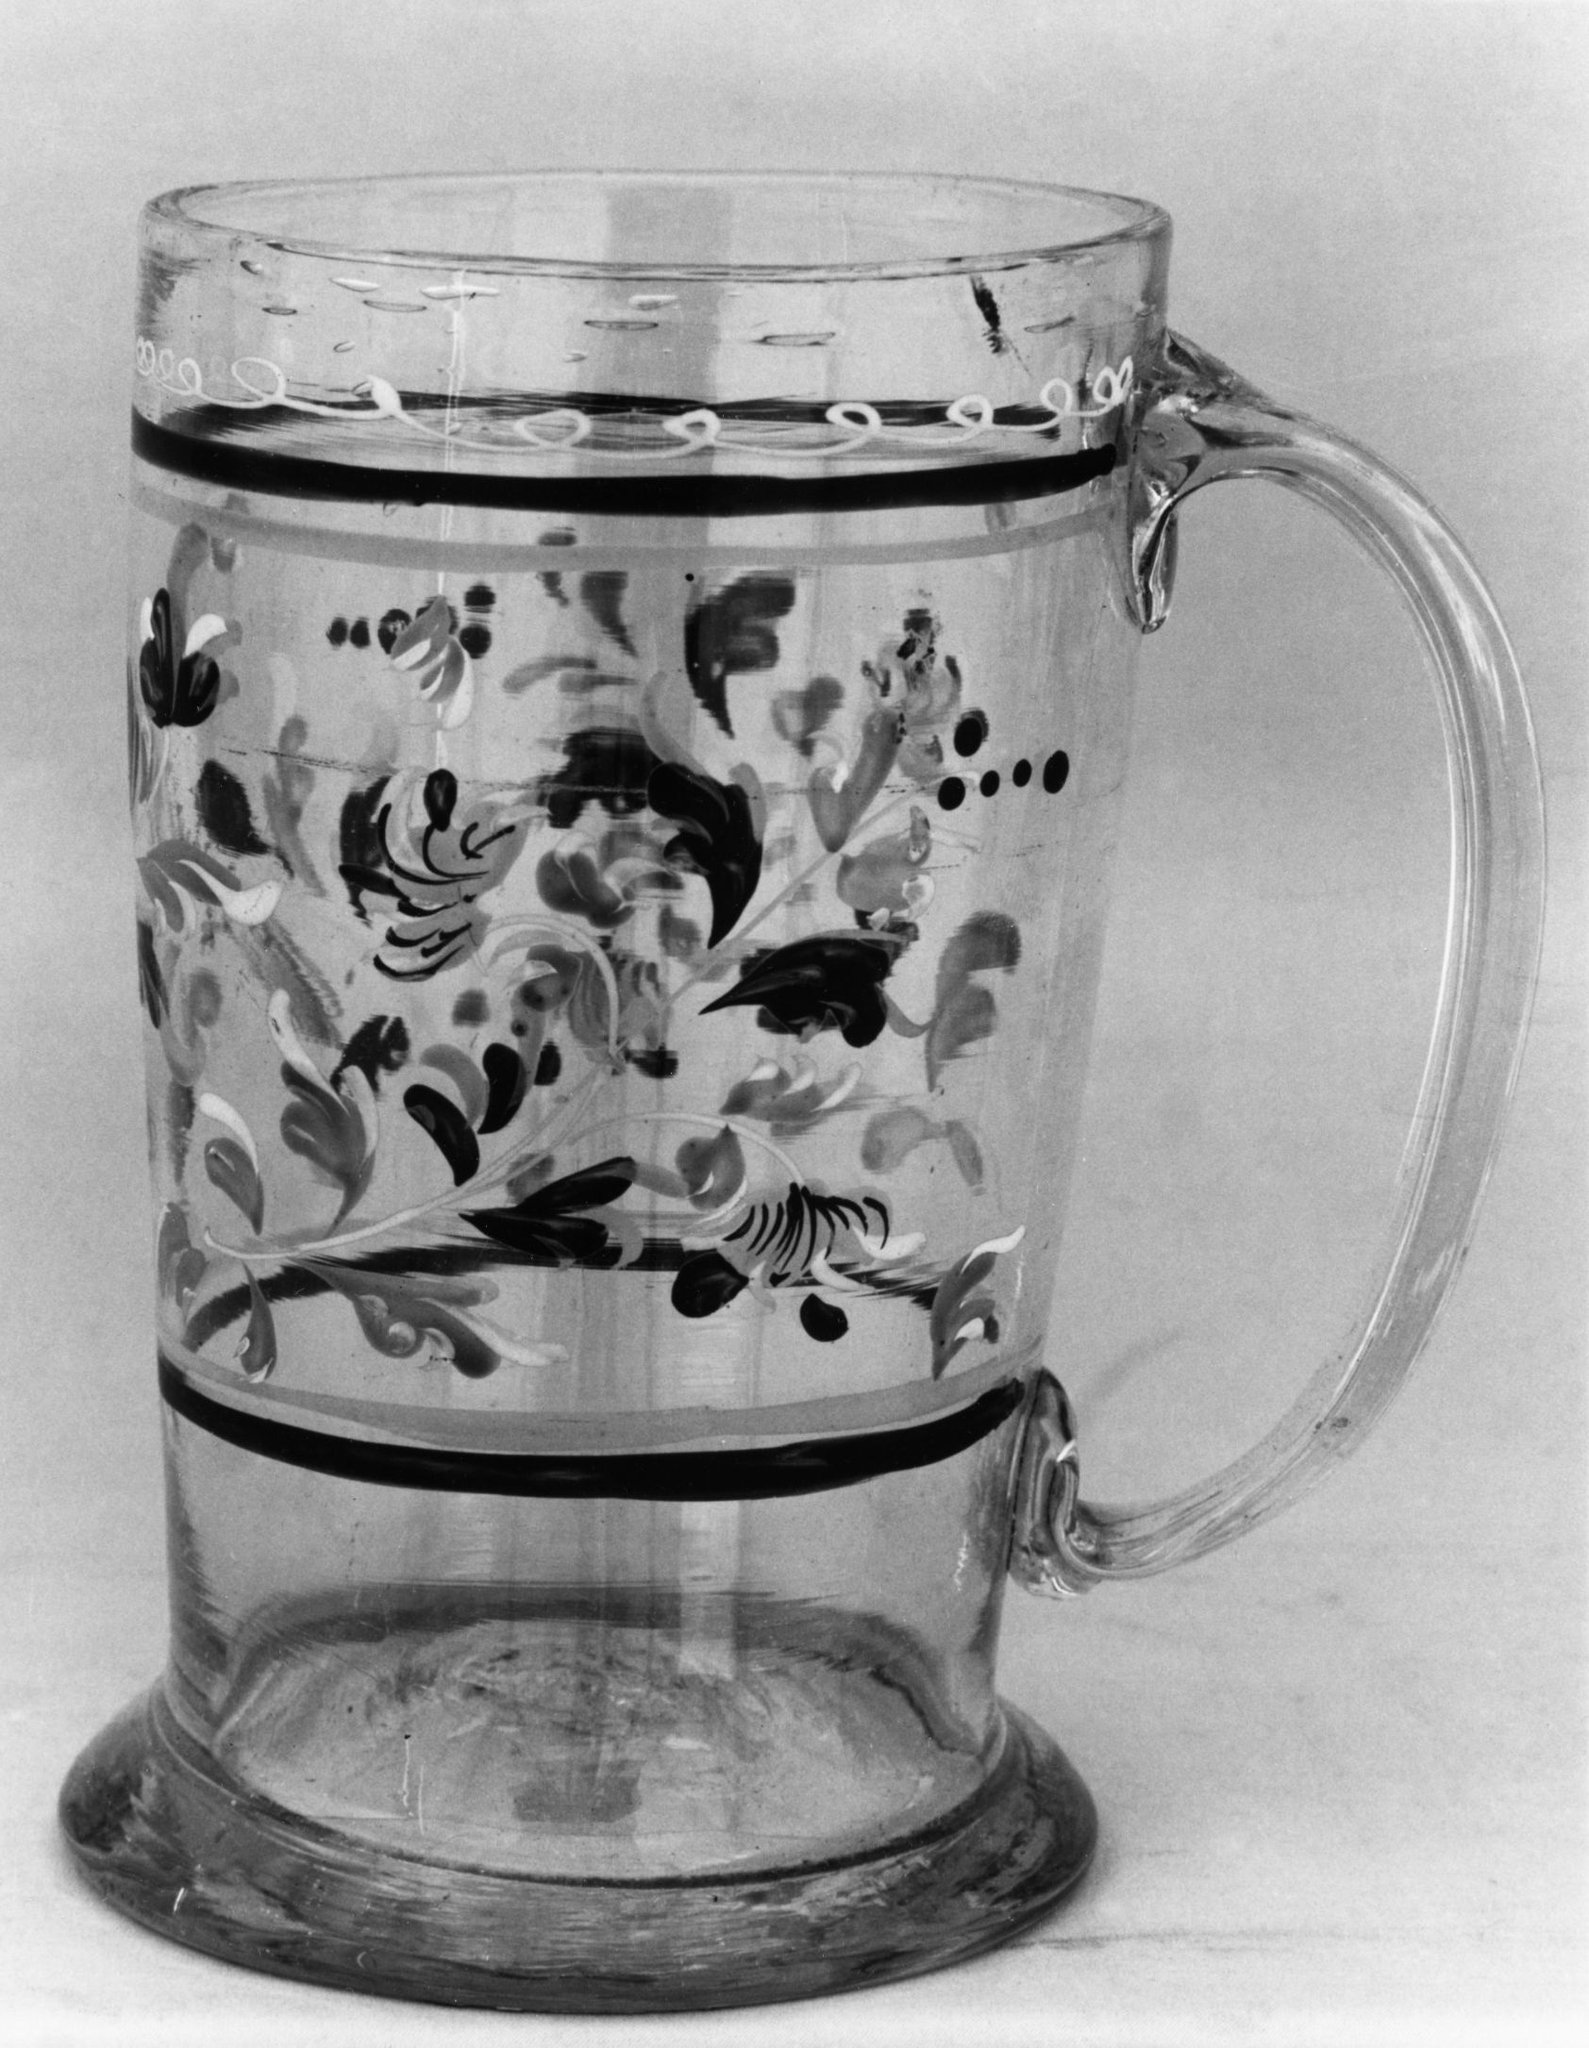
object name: mug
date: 1701-1800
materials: enamel, glass, lead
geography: czech republic